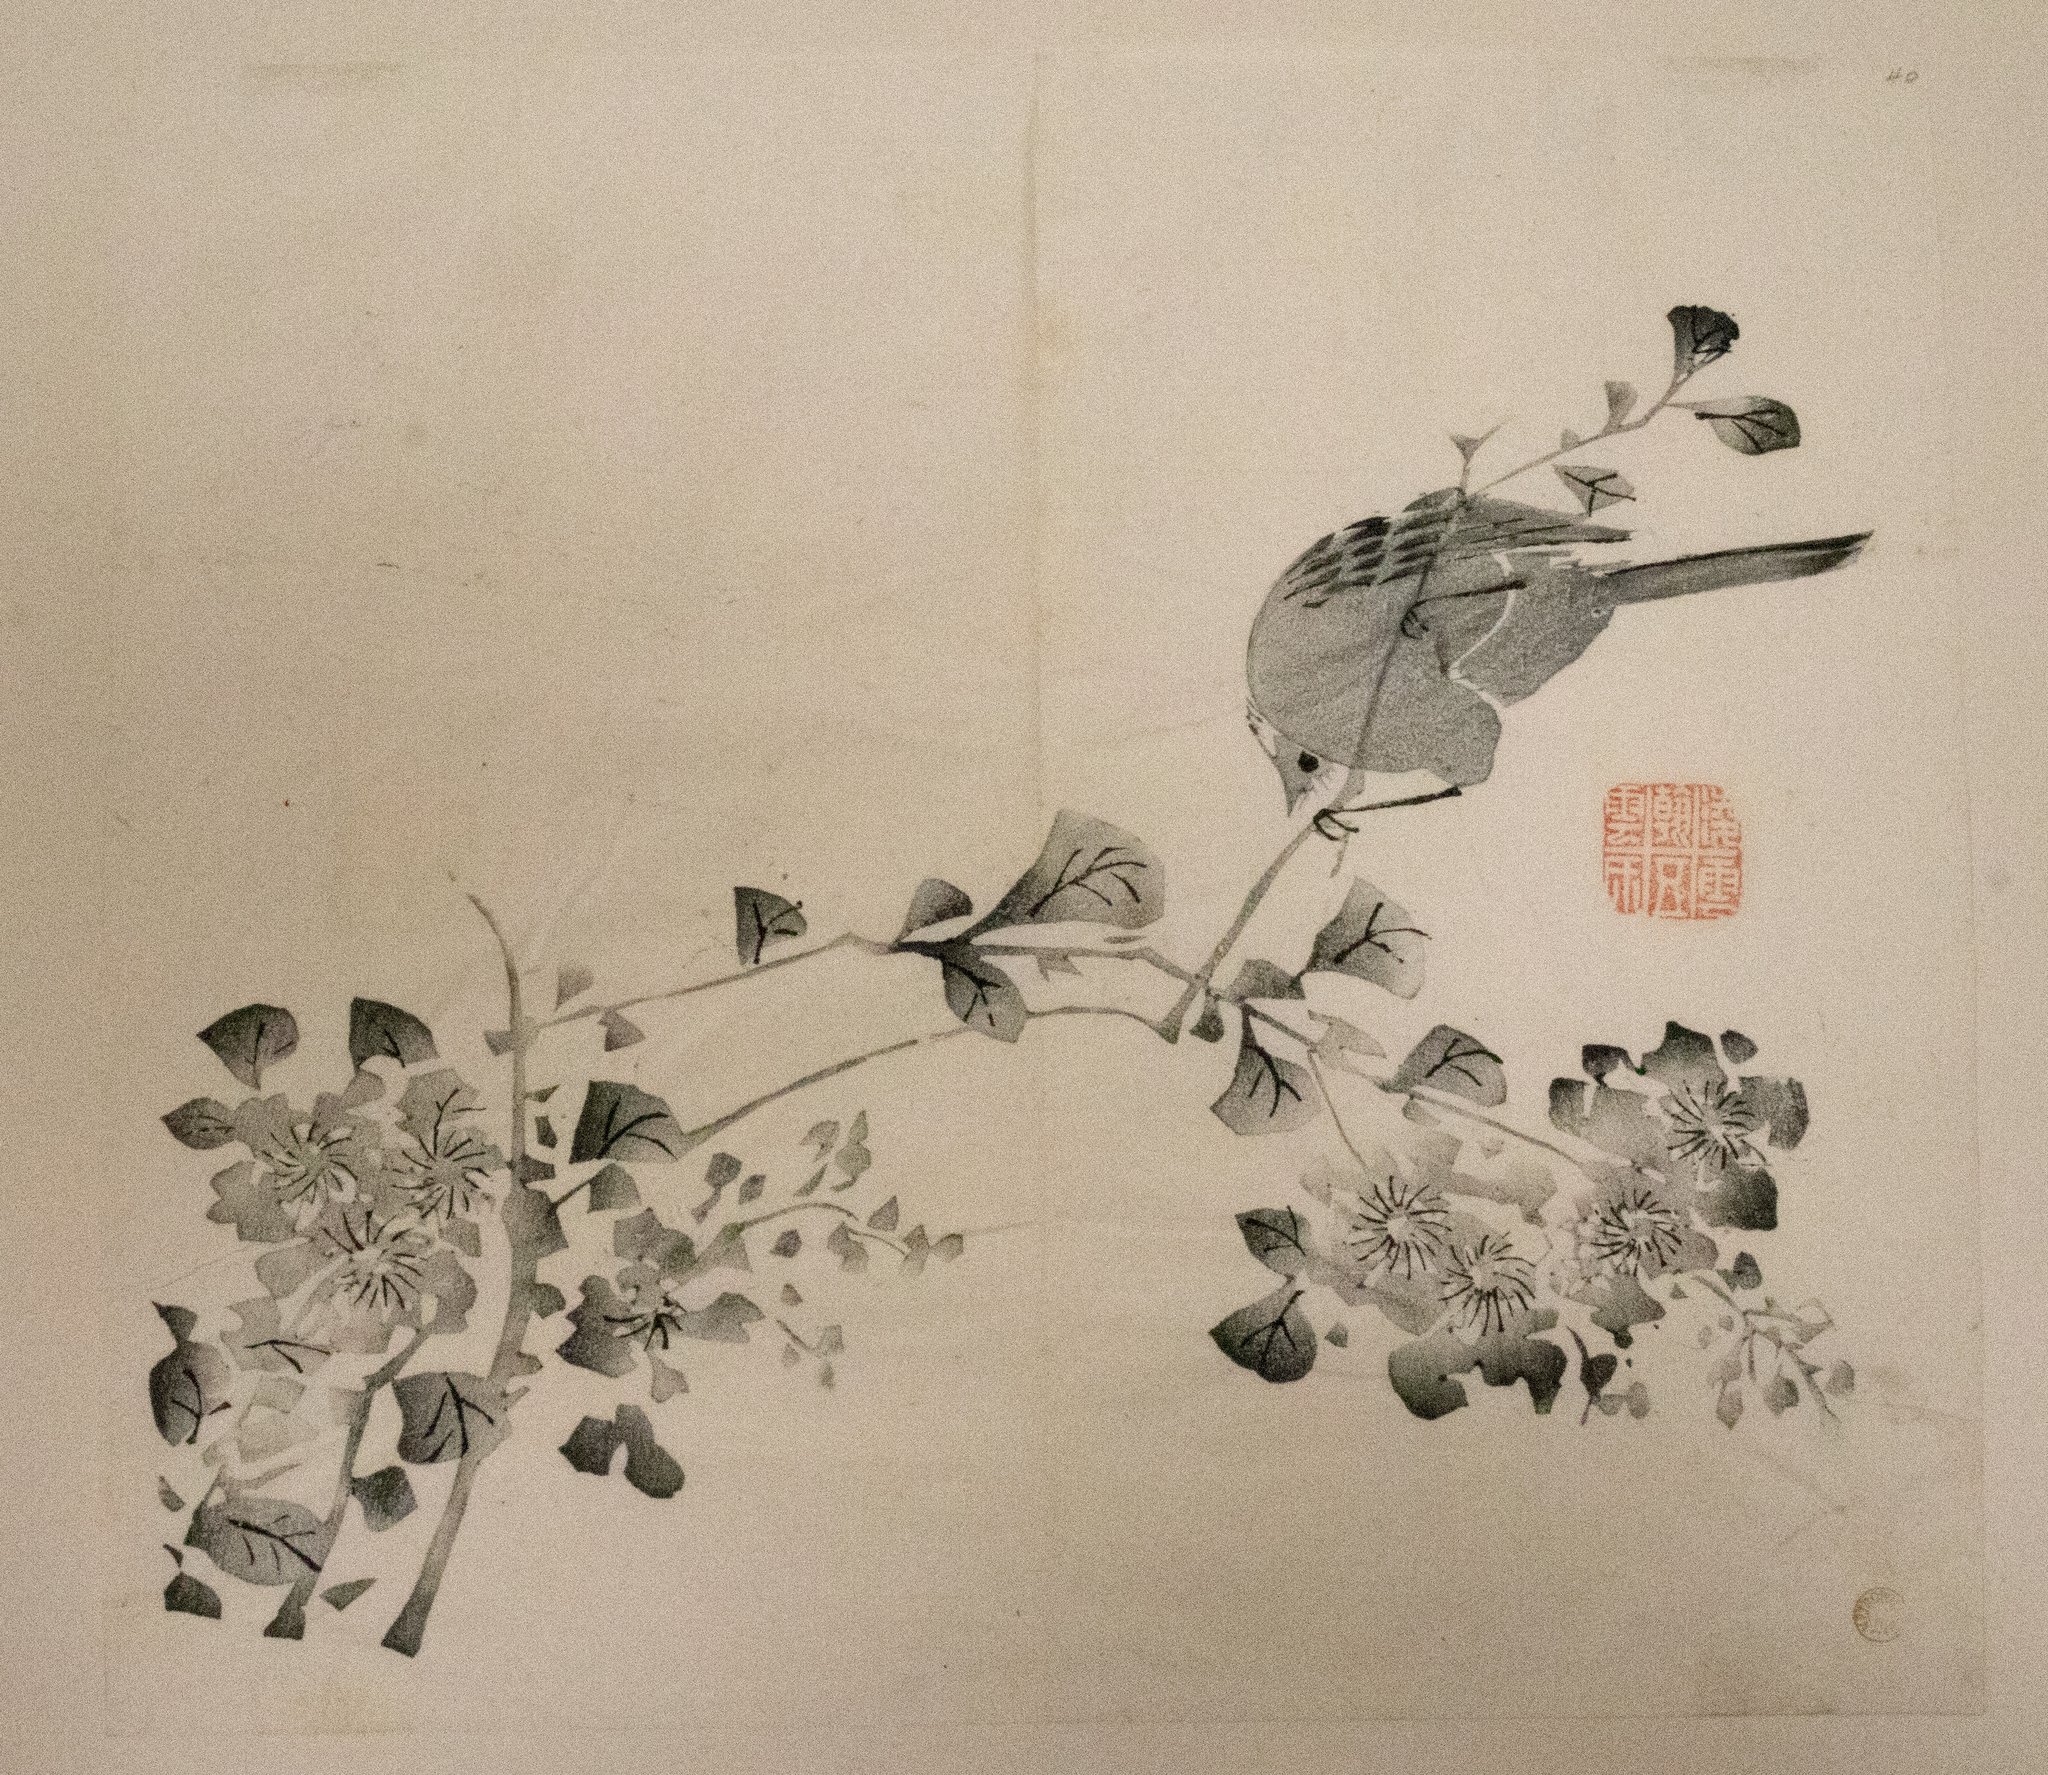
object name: print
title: Page from Shi Zhu Zhai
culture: chinese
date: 1736-1795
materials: ink, paper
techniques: polychrome, woodblock print